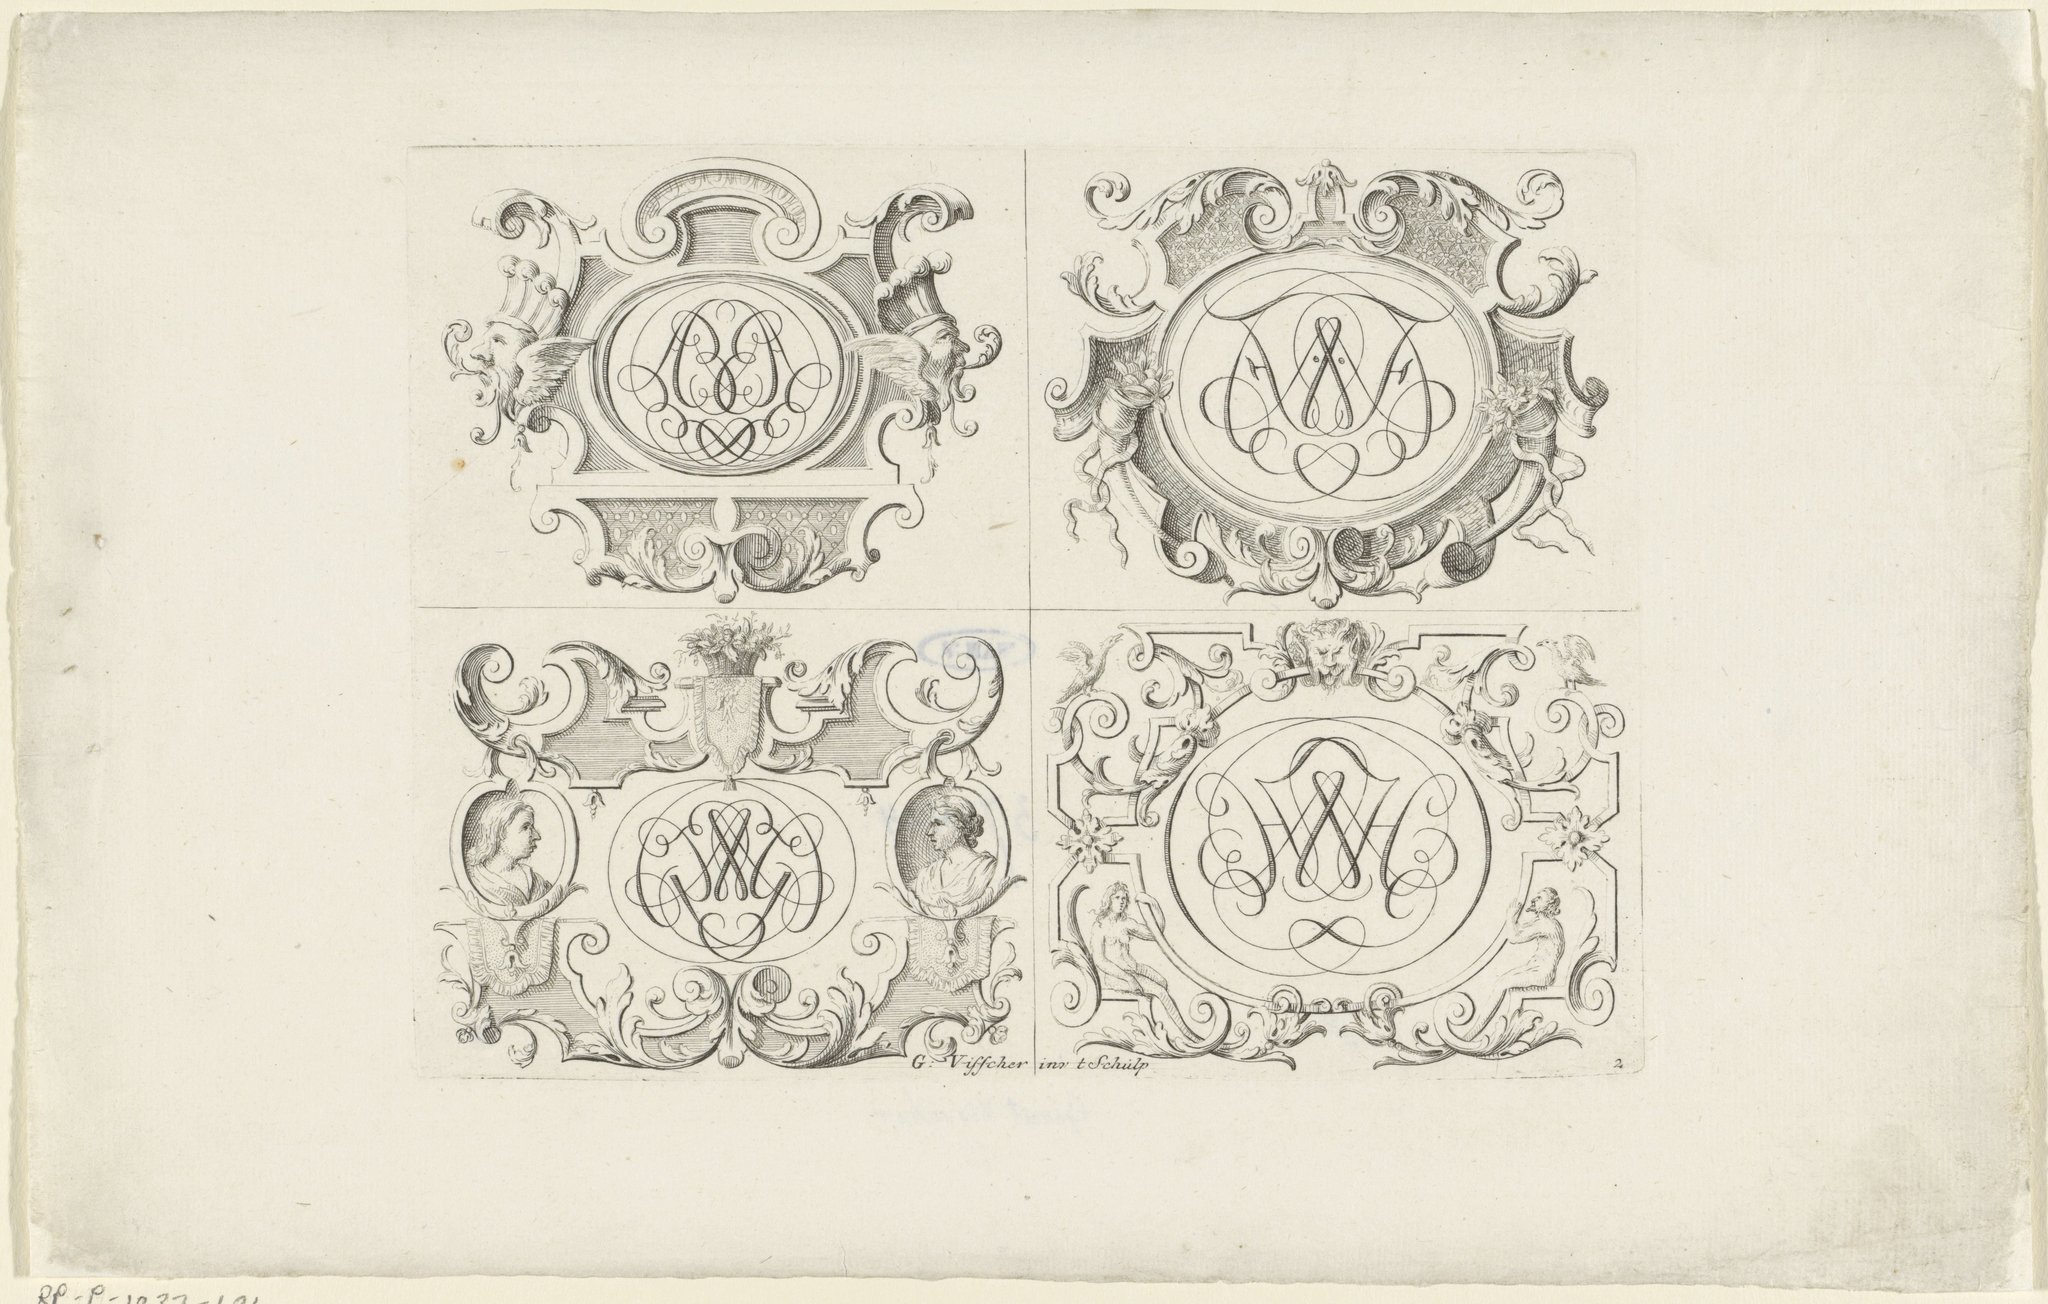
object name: ornament print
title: Het vierde Deel nieuwe t' Zaamen gevlogte naem Lettere gemaakt door Gerret Visscher tot Amsterdam op de Singel bij de Beuling Sluijs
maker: gerrit visscher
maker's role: print maker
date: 1690-1710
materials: paper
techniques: engraving, etching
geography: amsterdam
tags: ornaments ~ art, ornament ~ cartouche, letter combinations such as letterword, anagram, letter square, monogram, etc.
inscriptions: collector's mark: Lugt 2228, collector's mark: Lugt 2760